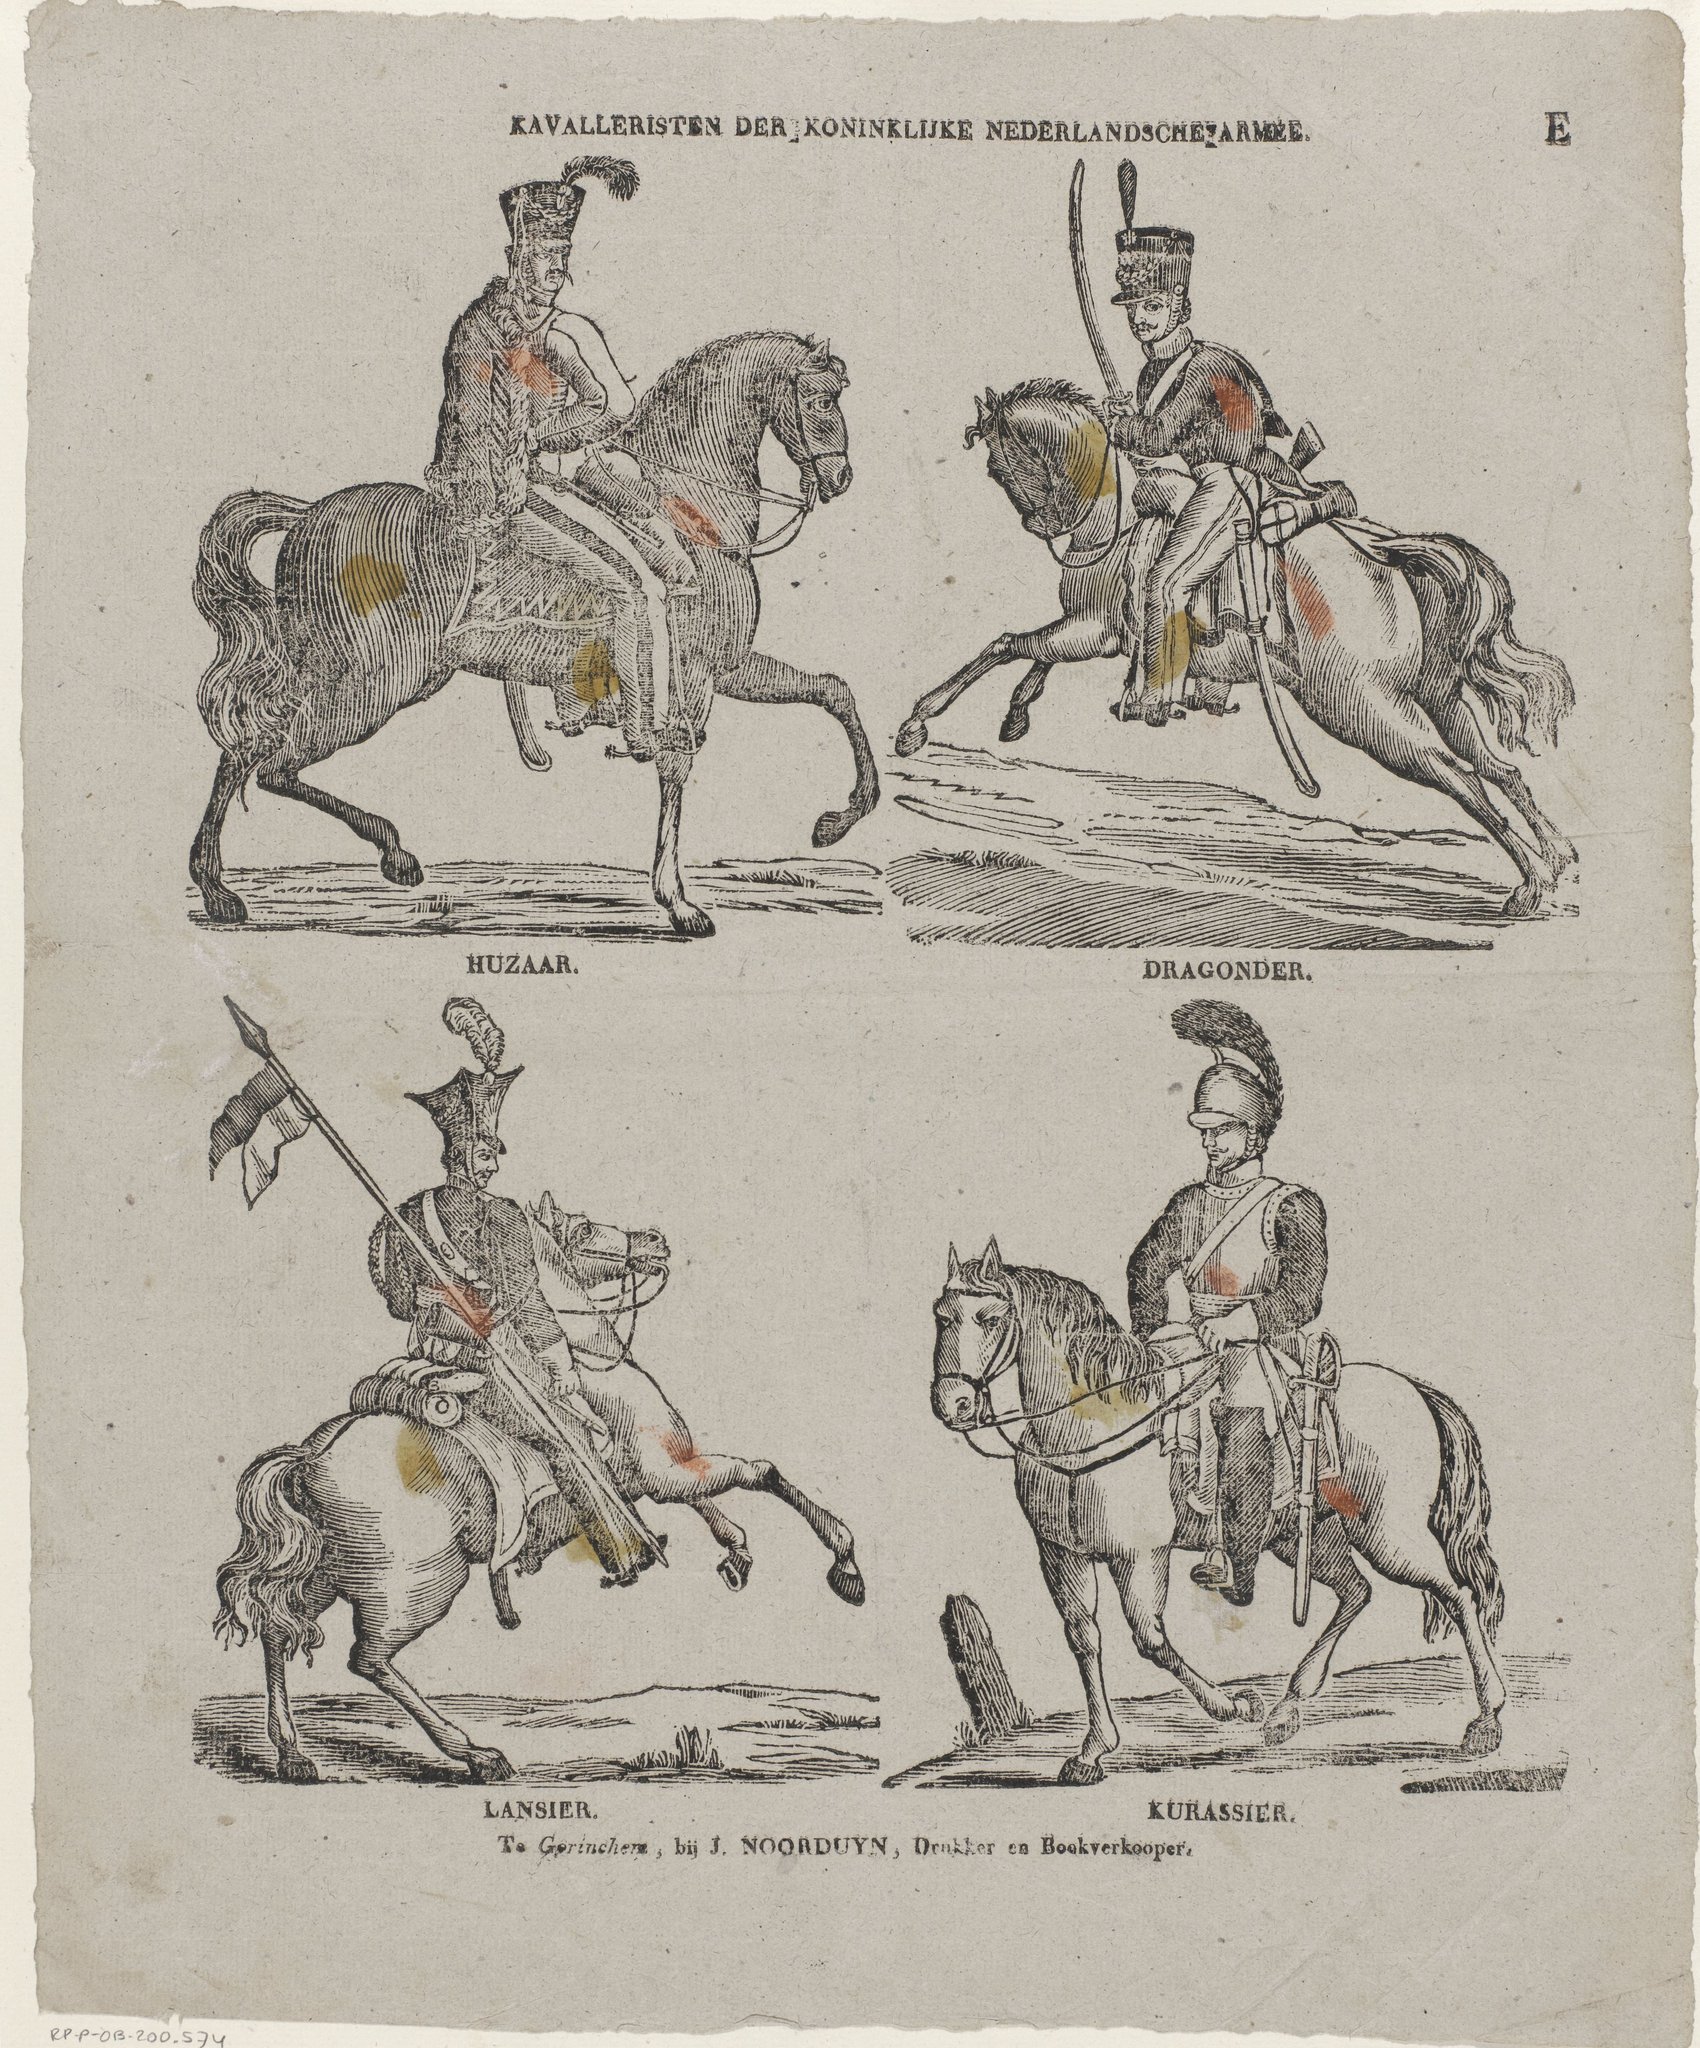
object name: print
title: Kavalleristen der koninklijke Nederlandsche armée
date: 1819-1840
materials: paper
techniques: colour, letterpress printing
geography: gorinchem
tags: warfare; military affairs (+ cavalry, horsemen), the soldier; the soldier's life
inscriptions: collector's mark: Lugt 2760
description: Blad met 4 voorstellingen van soldaten te paard. Onder elke voorstelling een onderschrift. Gemerkt rechtsboven: E.